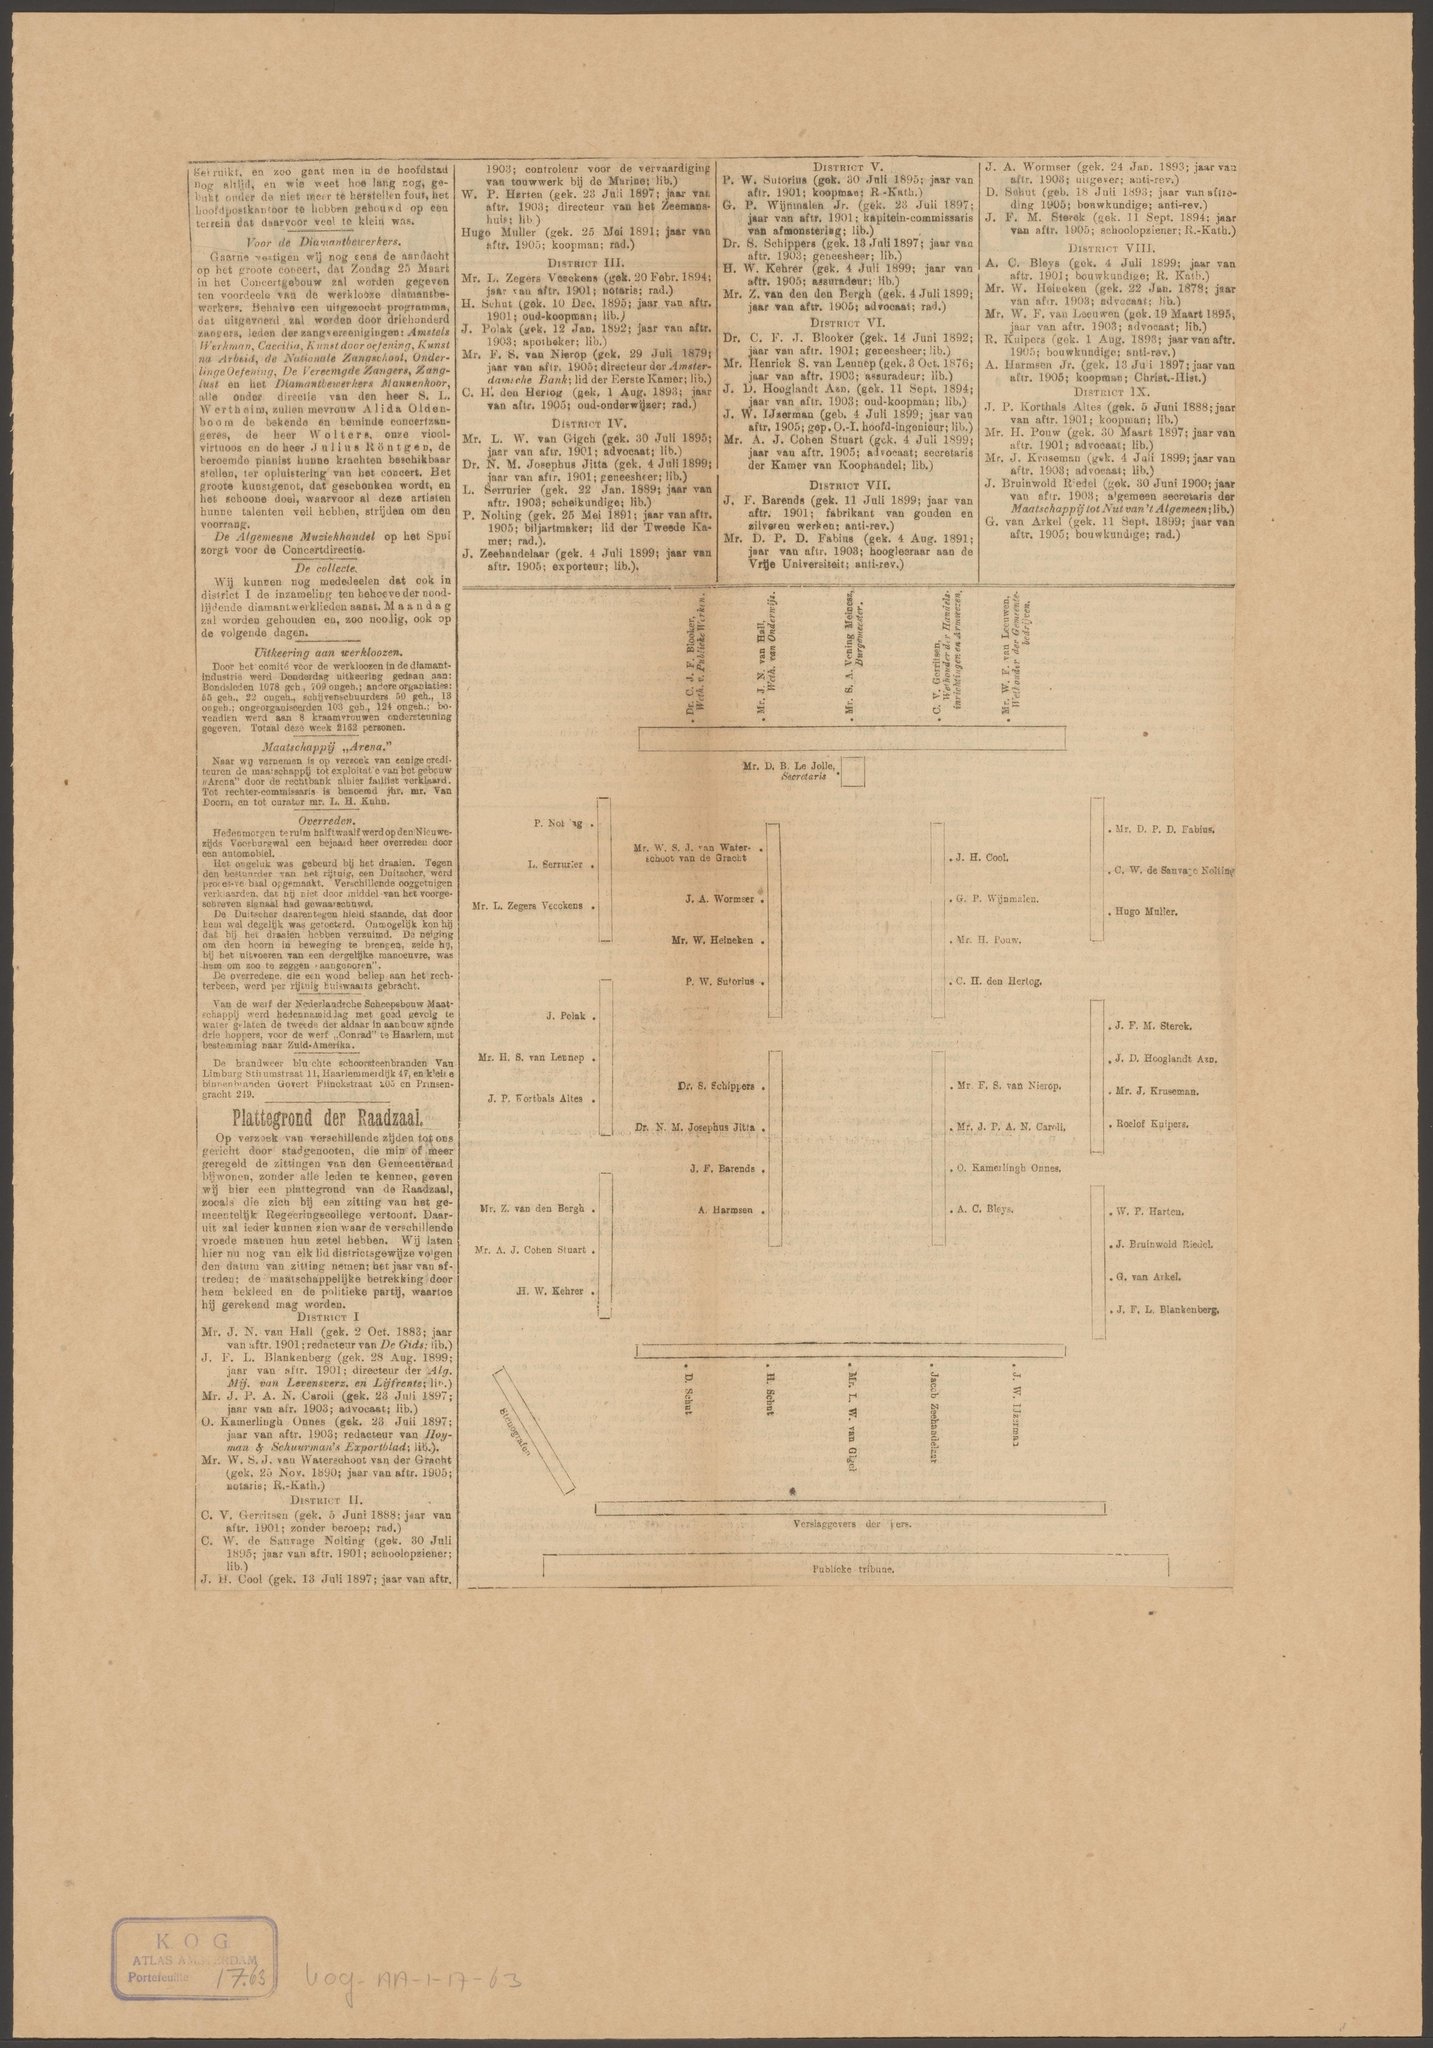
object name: photomechanical print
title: Plattegrond van de Raadzaal van het stadhuis op het Prinsenhof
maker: Anonymous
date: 1905-1950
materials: paper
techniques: letterpress printing, line block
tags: townhall, plan ~ architecture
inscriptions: collector's mark: ‘17.63’ Lugt 1641b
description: Onderwerpsrubriek binnen de Atlas Amsterdam: Nieuwe Stadhuis, van binnen: Vaartuigen en Gebouwen ten dienste der Stedelijke Regeering en Administratie; Stadhuis (Prinsenhof).